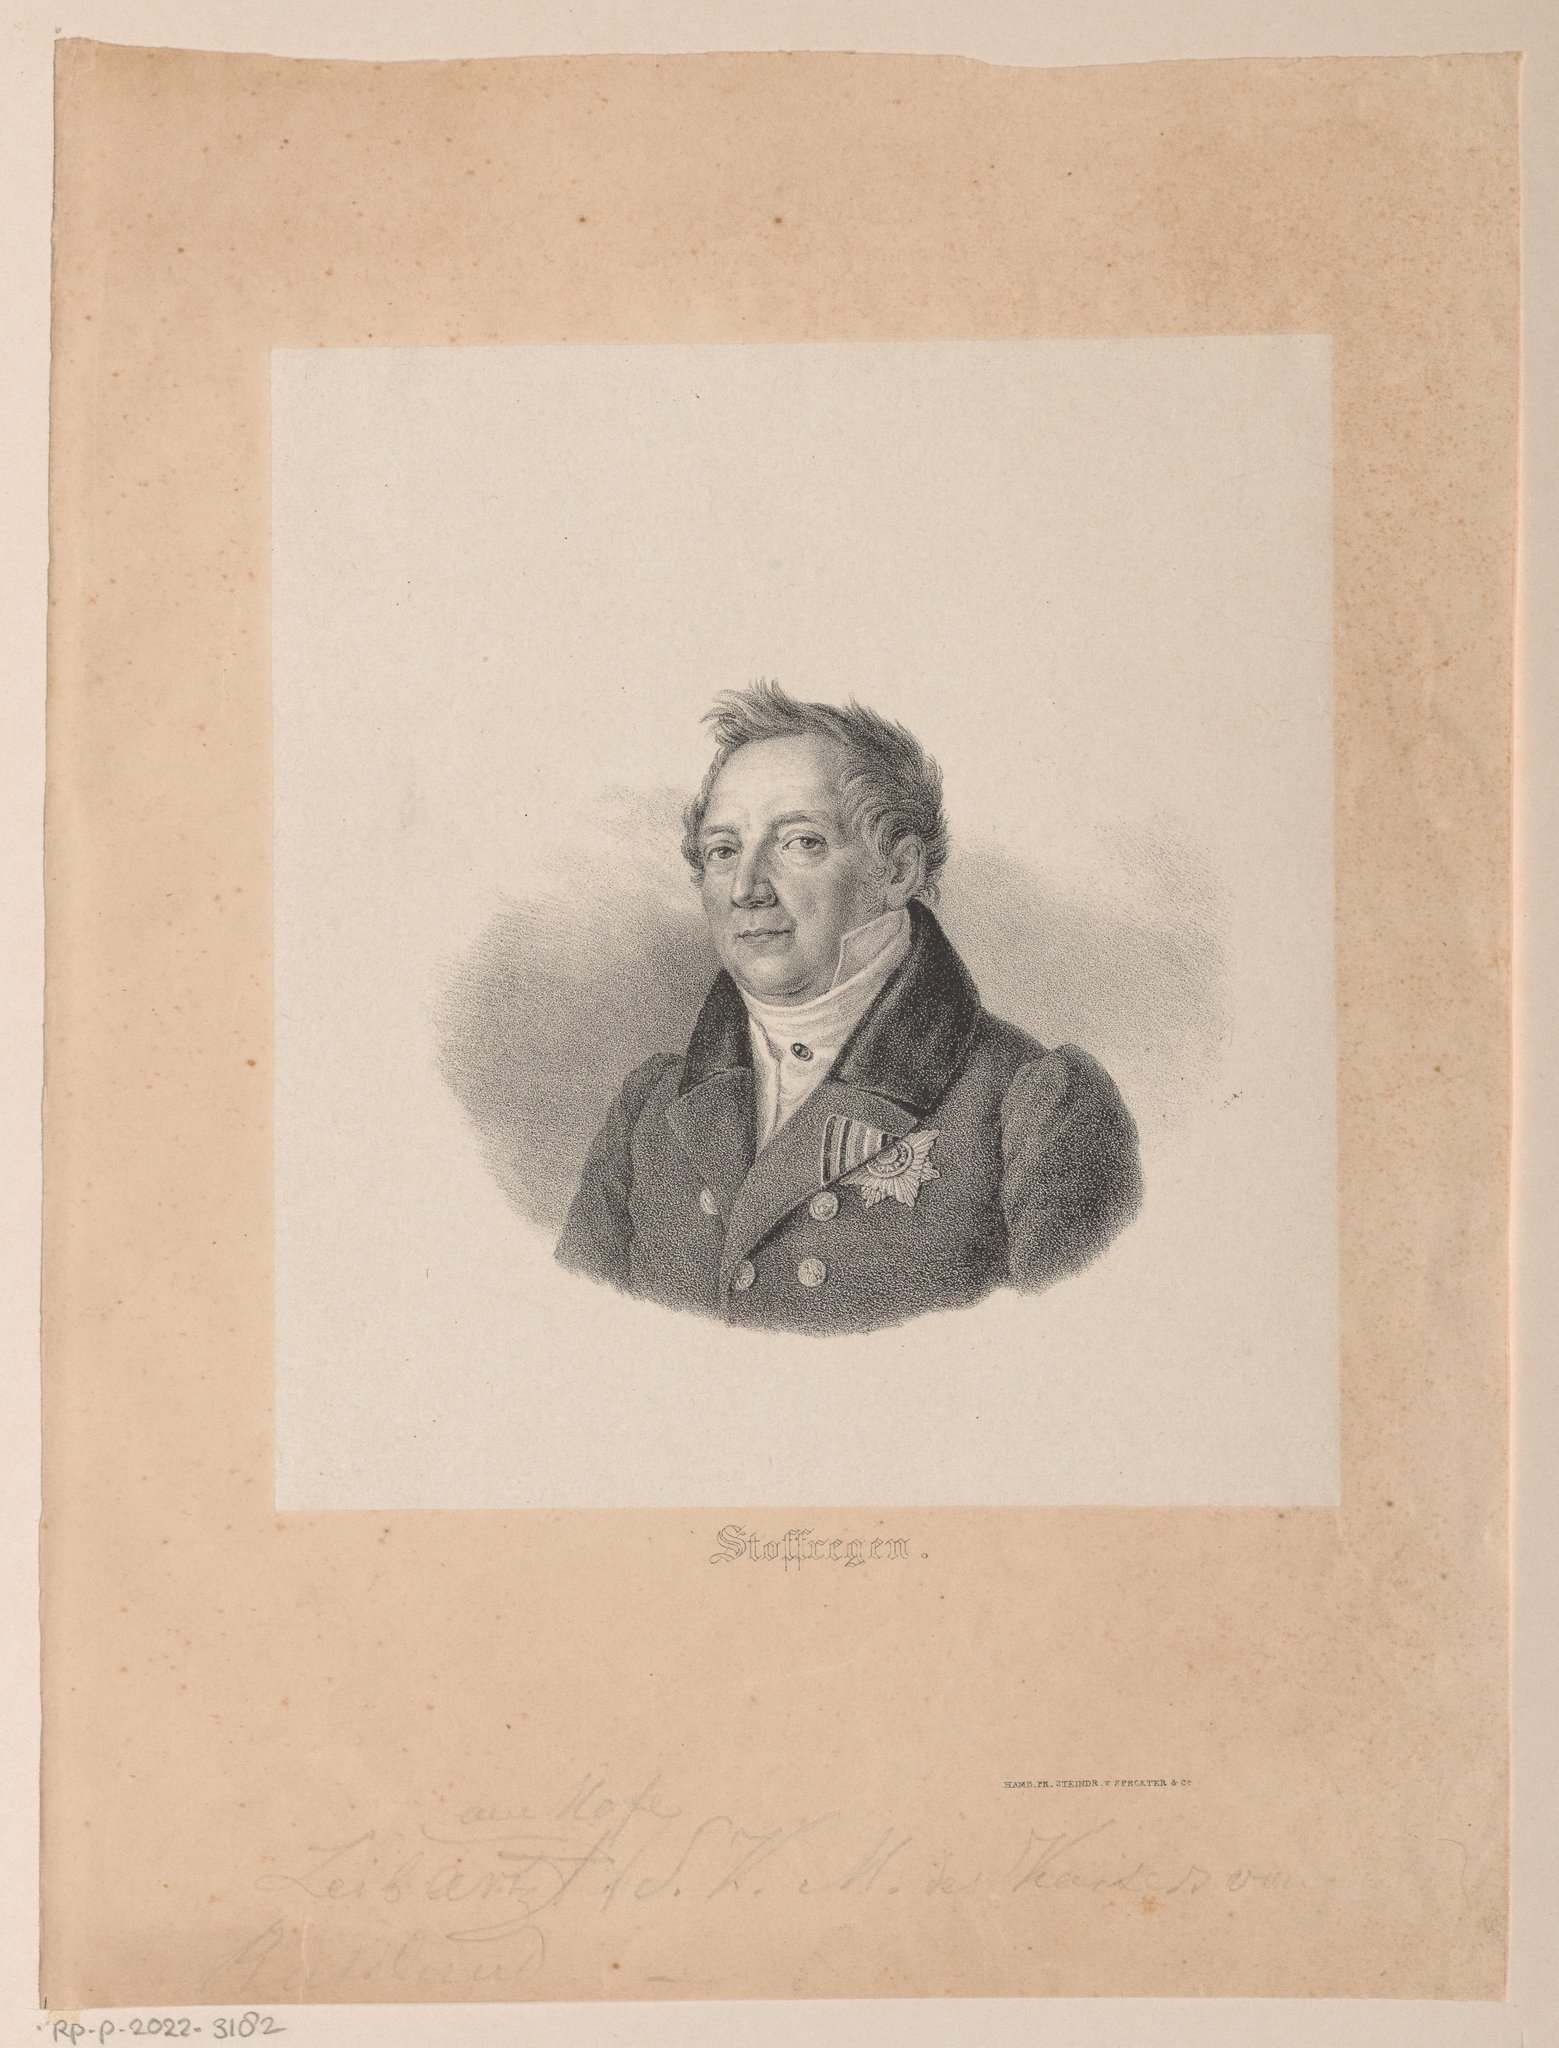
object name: print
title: Portret van Konrad Christian von Stoffregen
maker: Anonymous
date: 1820-1885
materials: paper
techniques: lithograph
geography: hamburg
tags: historical persons, physician, doctor